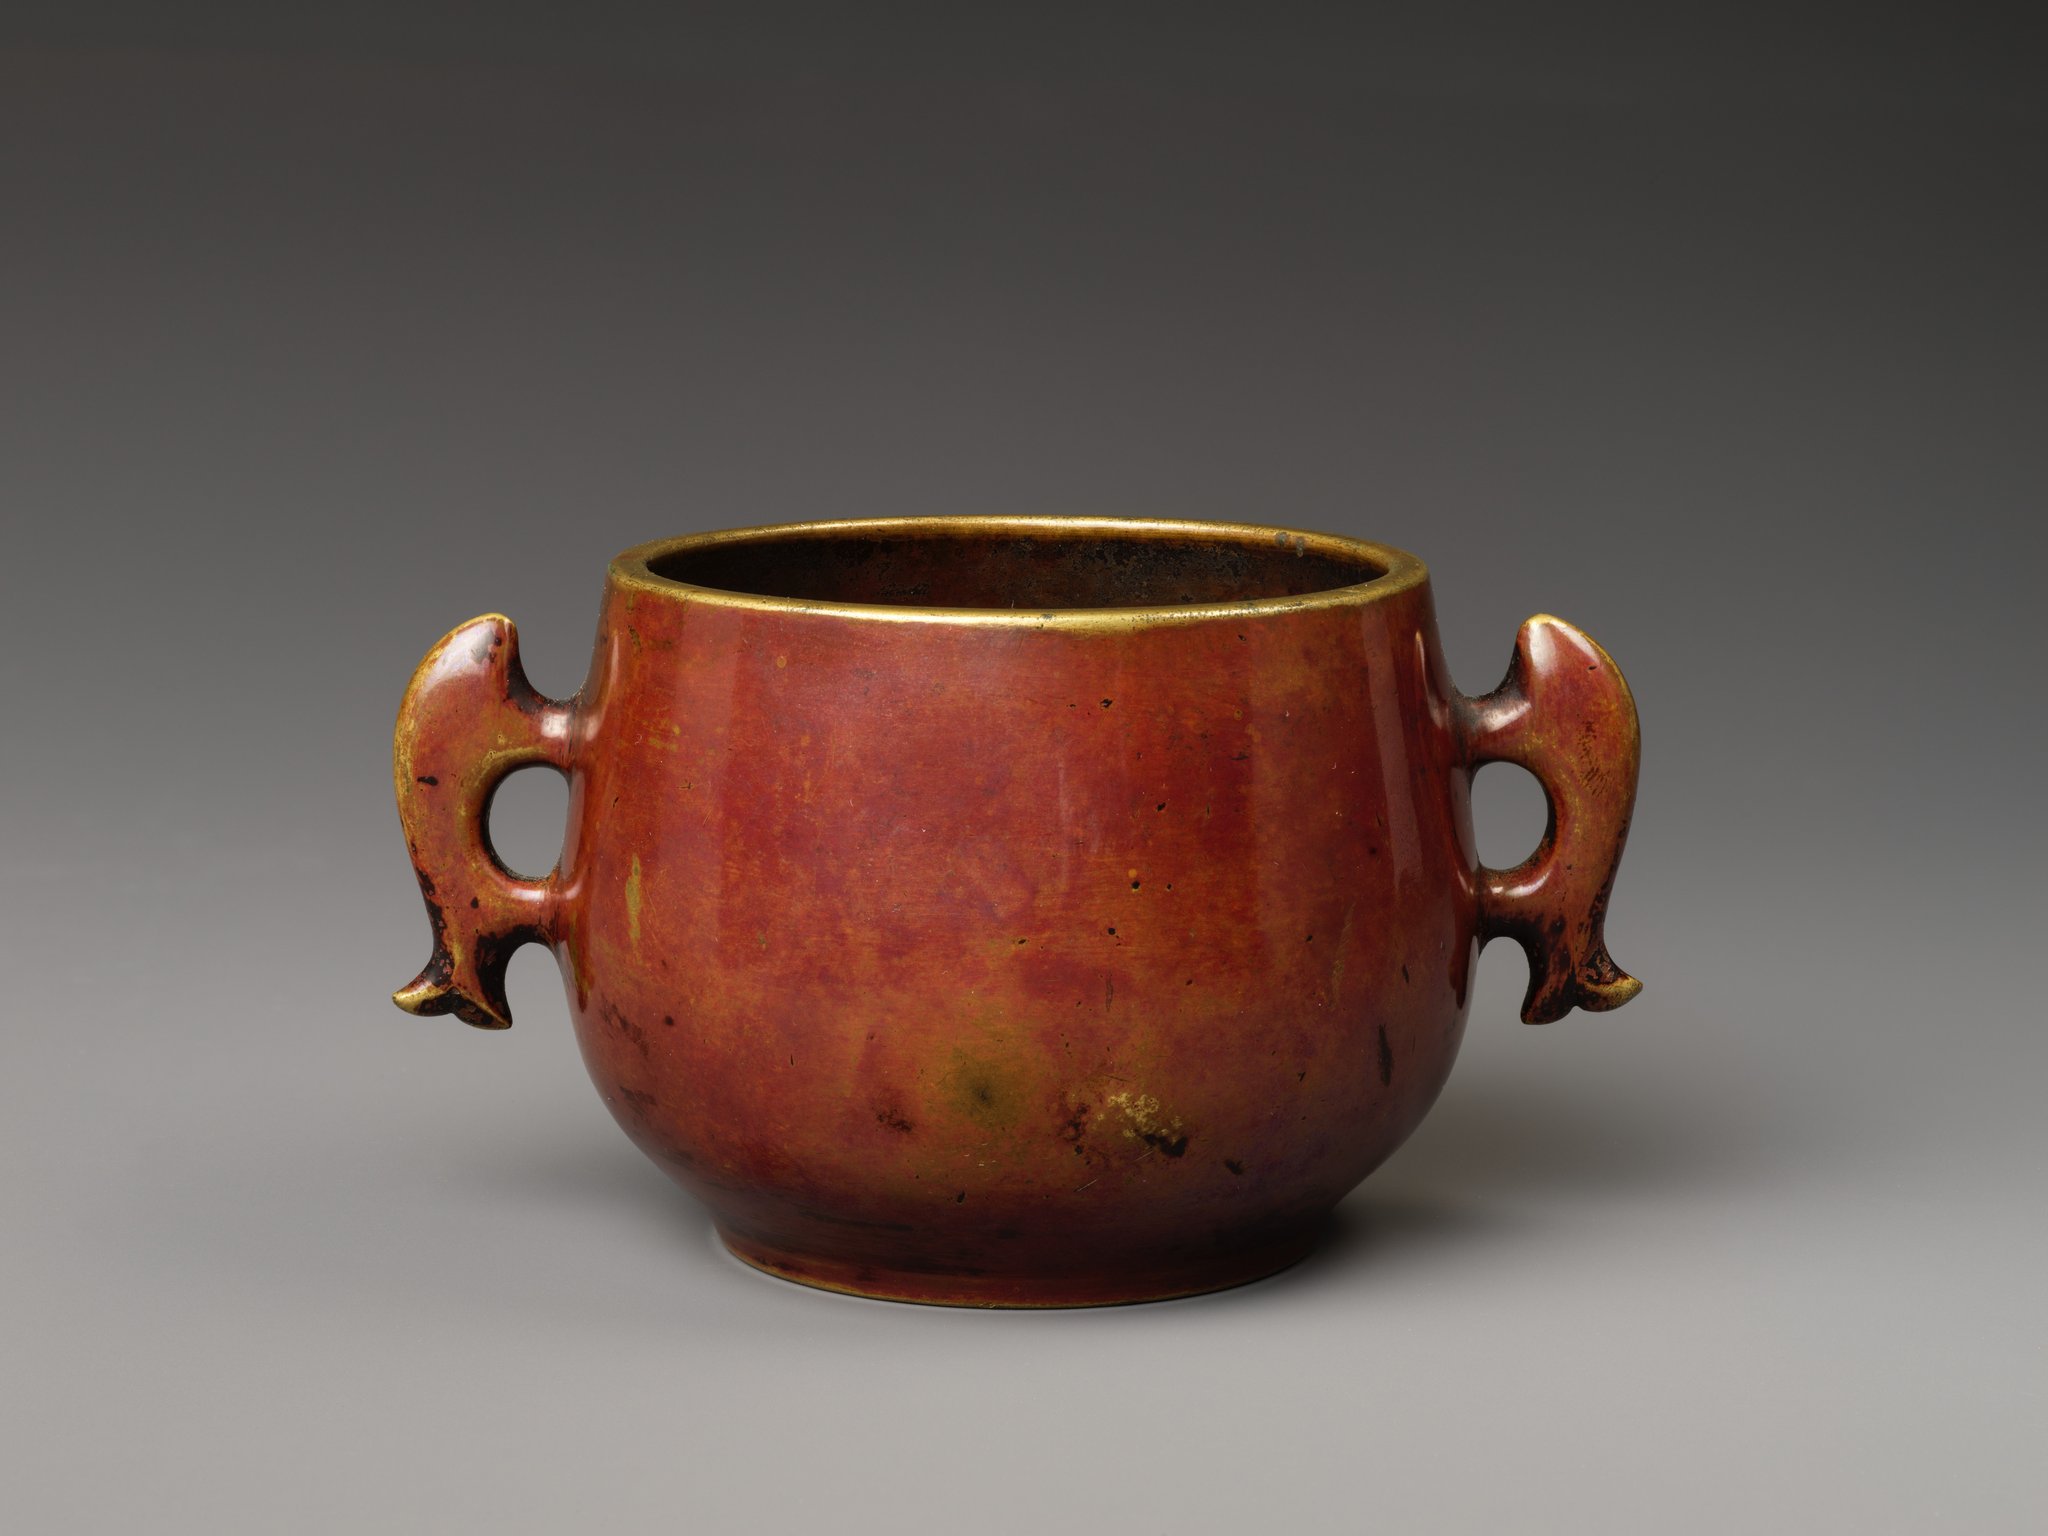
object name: incense burner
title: Incense burner with fish-shaped handles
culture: chinese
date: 1501-1700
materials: copper alloy